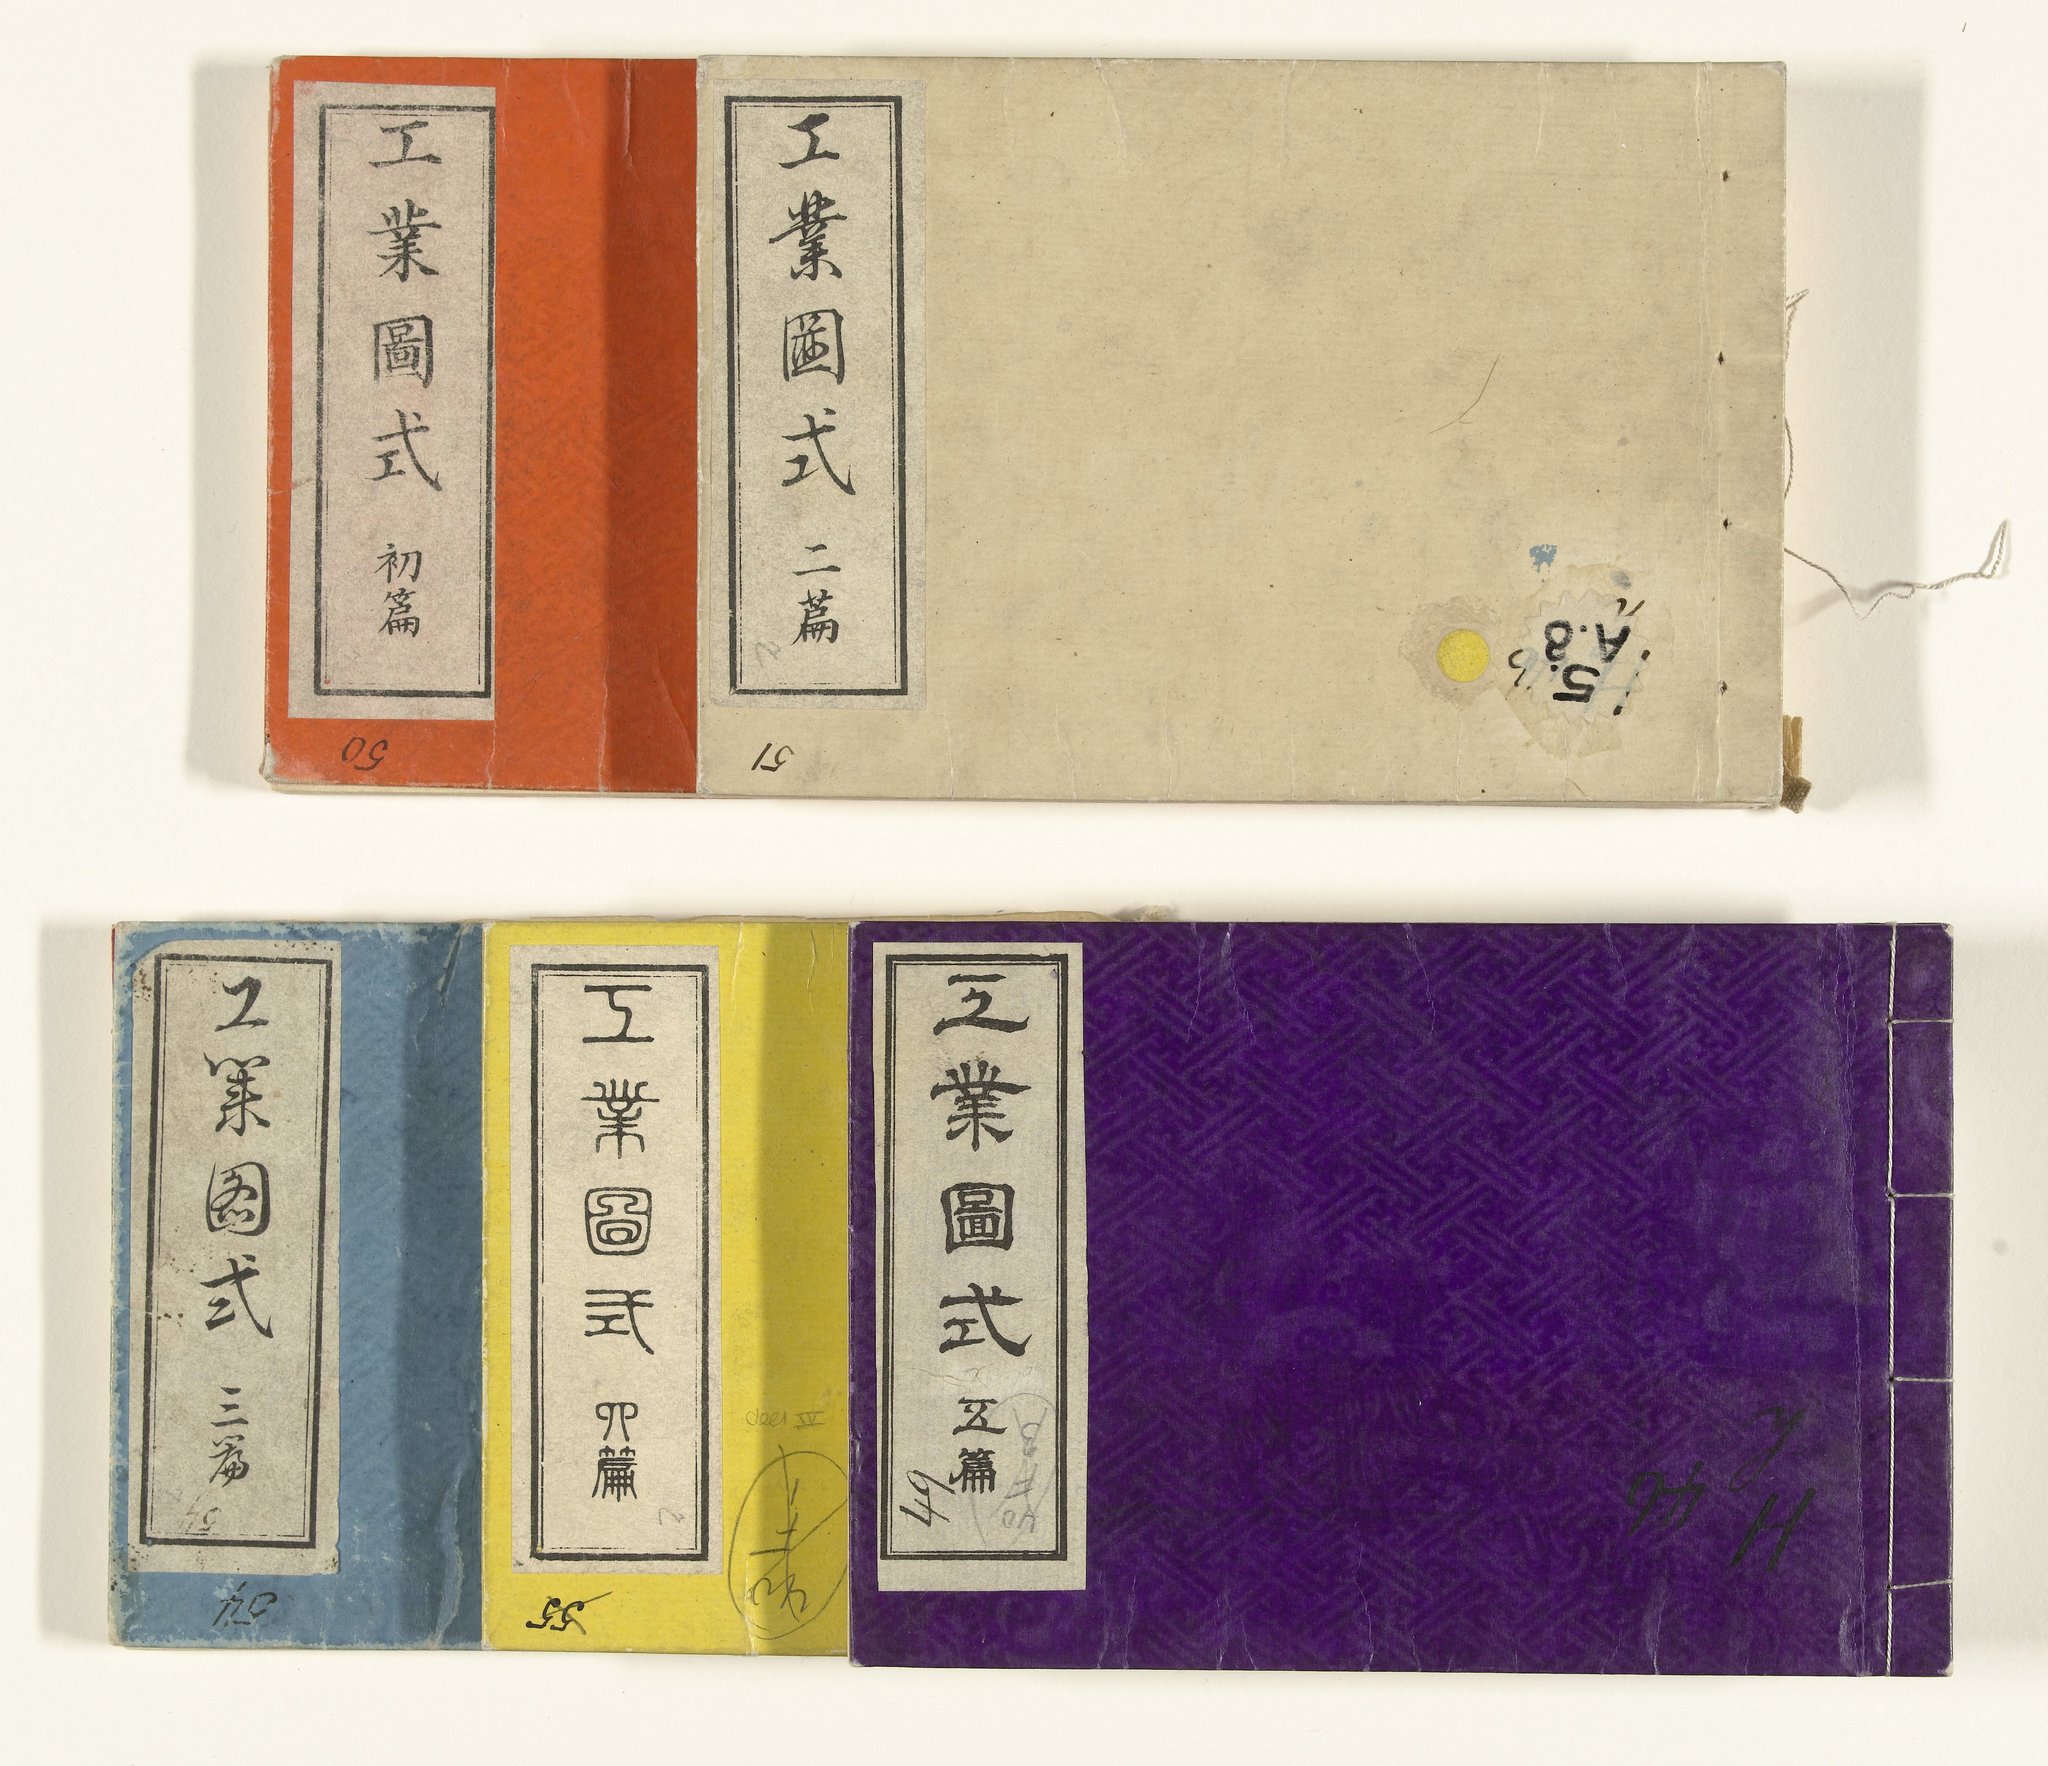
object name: book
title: Kogyo zushiki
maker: kôno bairei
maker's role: painter, print maker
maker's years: 1844-1895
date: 1883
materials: paper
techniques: woodcut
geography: tokyo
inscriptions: collector's mark: ‘Rijksschool voor kunstnijverheid’ Lugt 3937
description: Vijf delen (van vijf) met schetsen van mensen, dieren en landschappen.